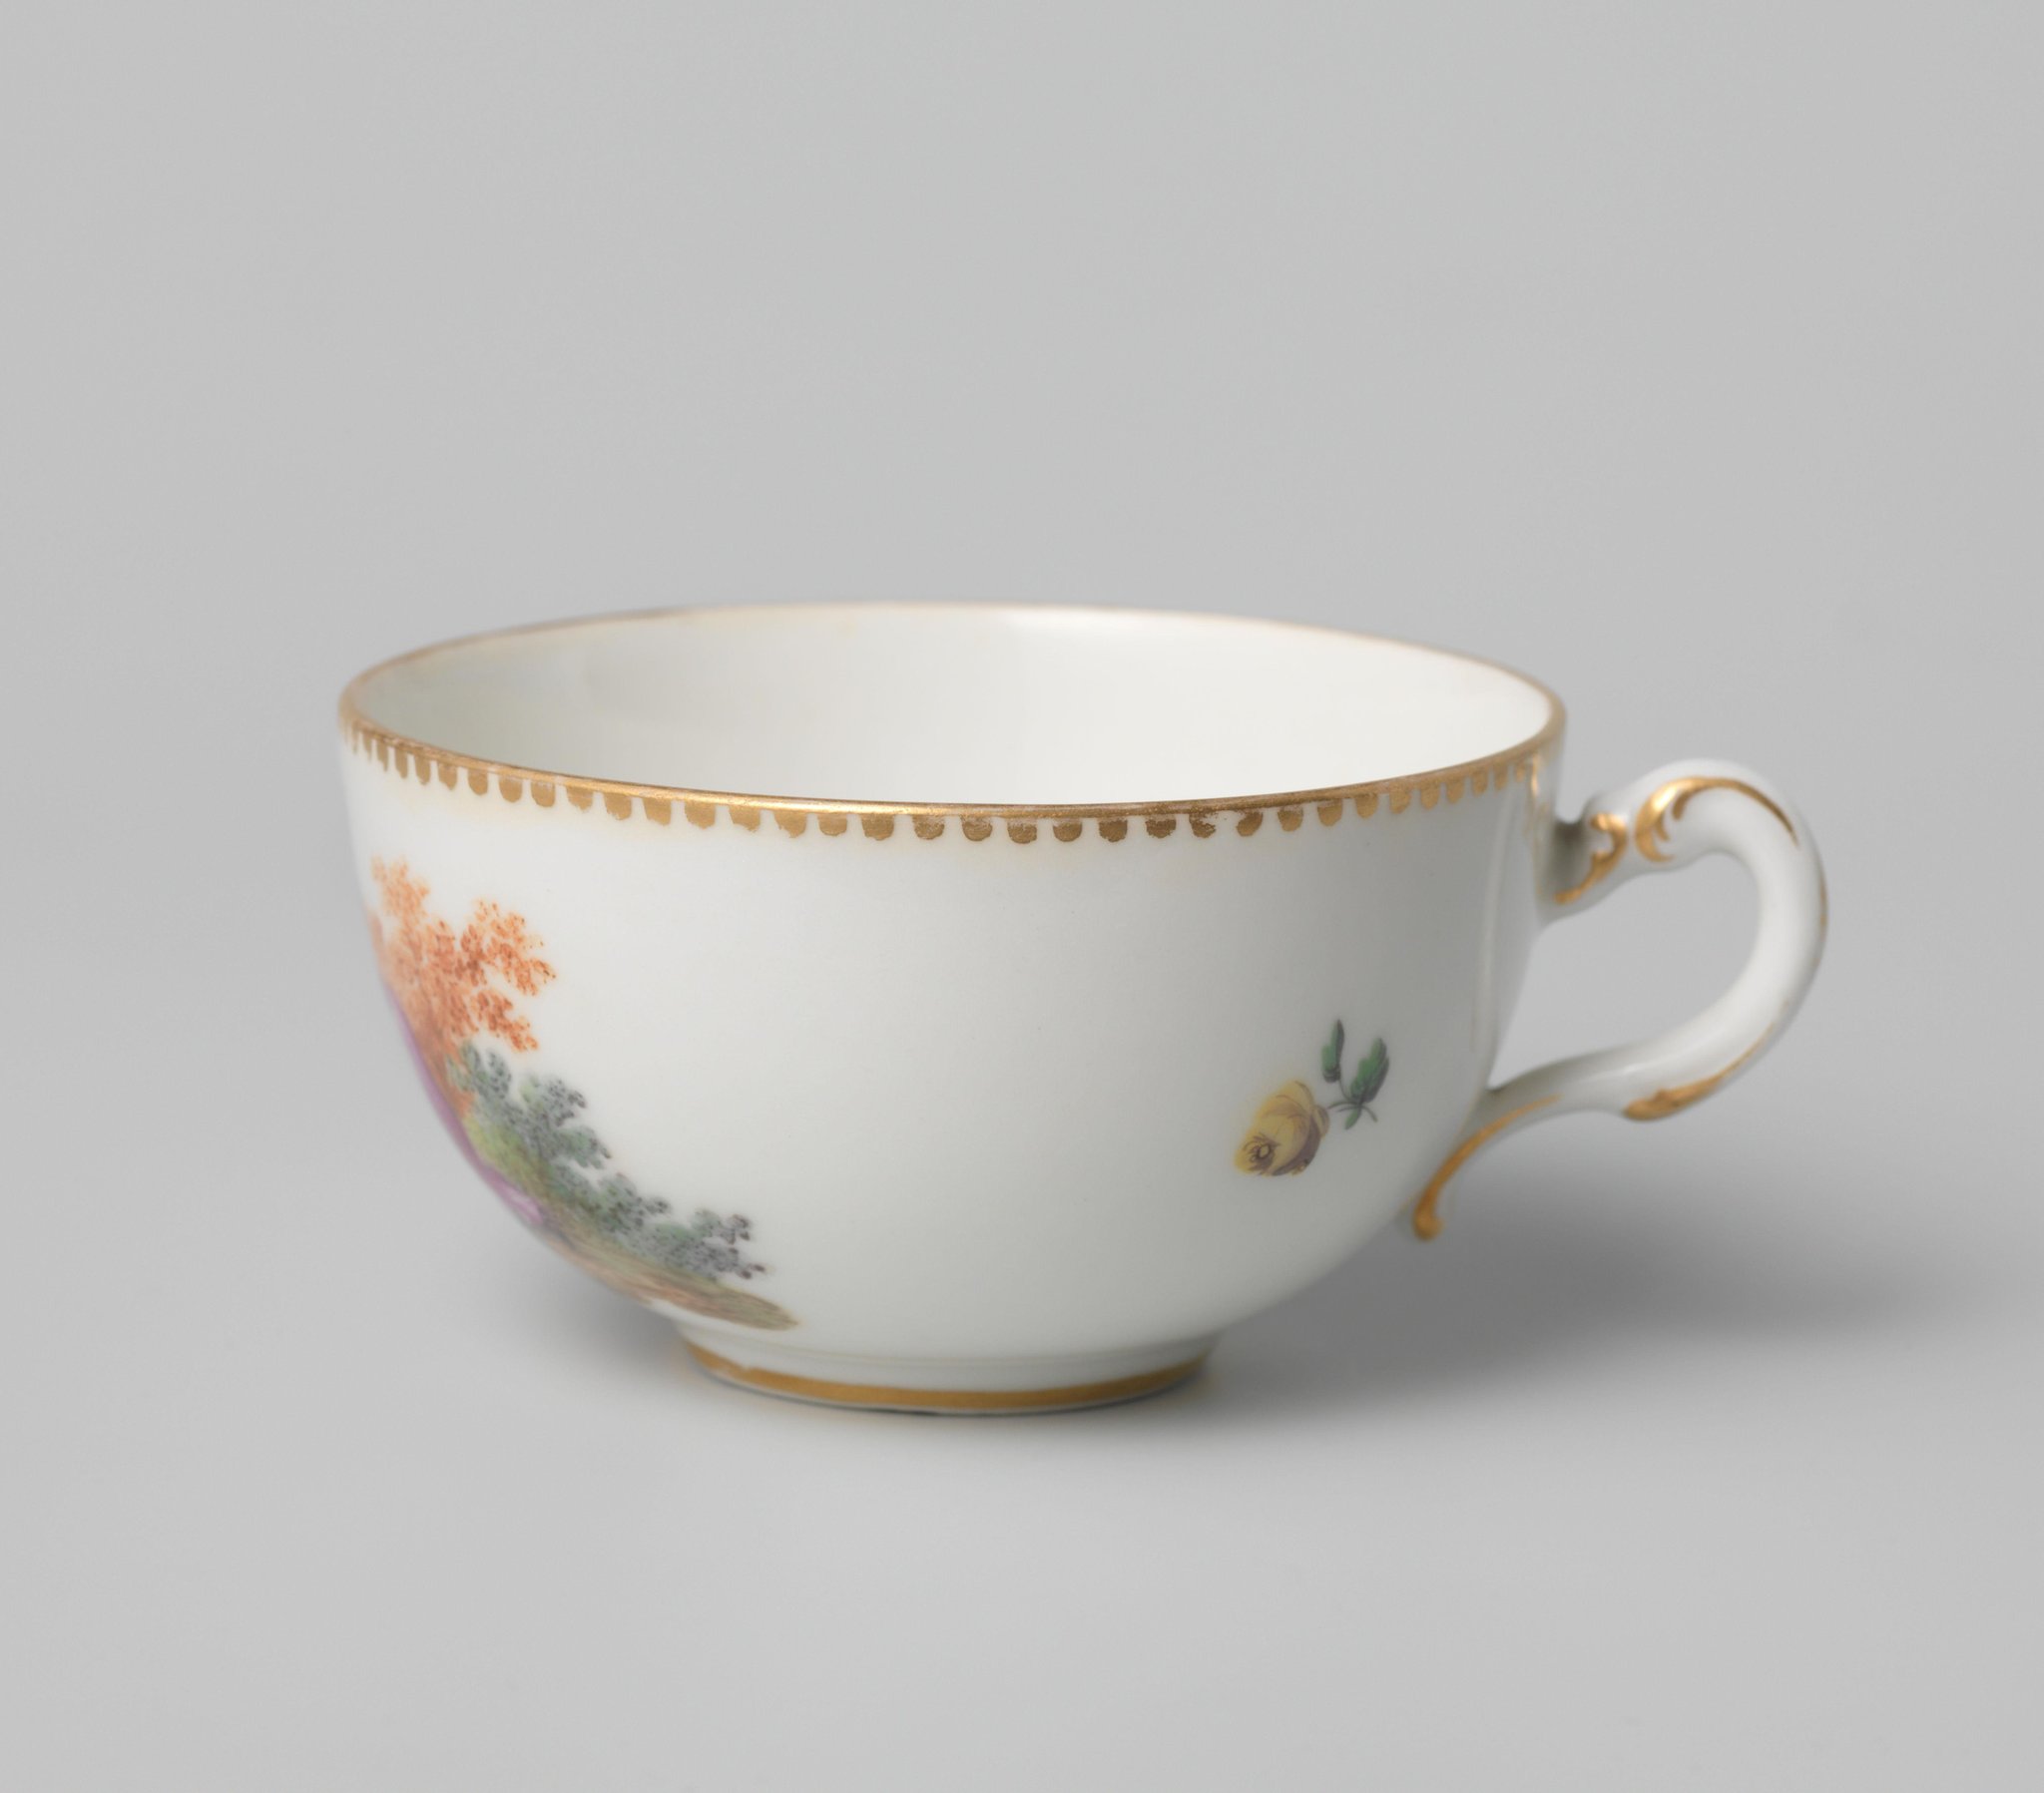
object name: cup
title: Kop, beschilderd met een vrijend paartje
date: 1782-1784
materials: porcelain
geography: loosdrecht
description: Cup and saucer. Porcelain. Loosdrecht, c. 1780 - 1784.